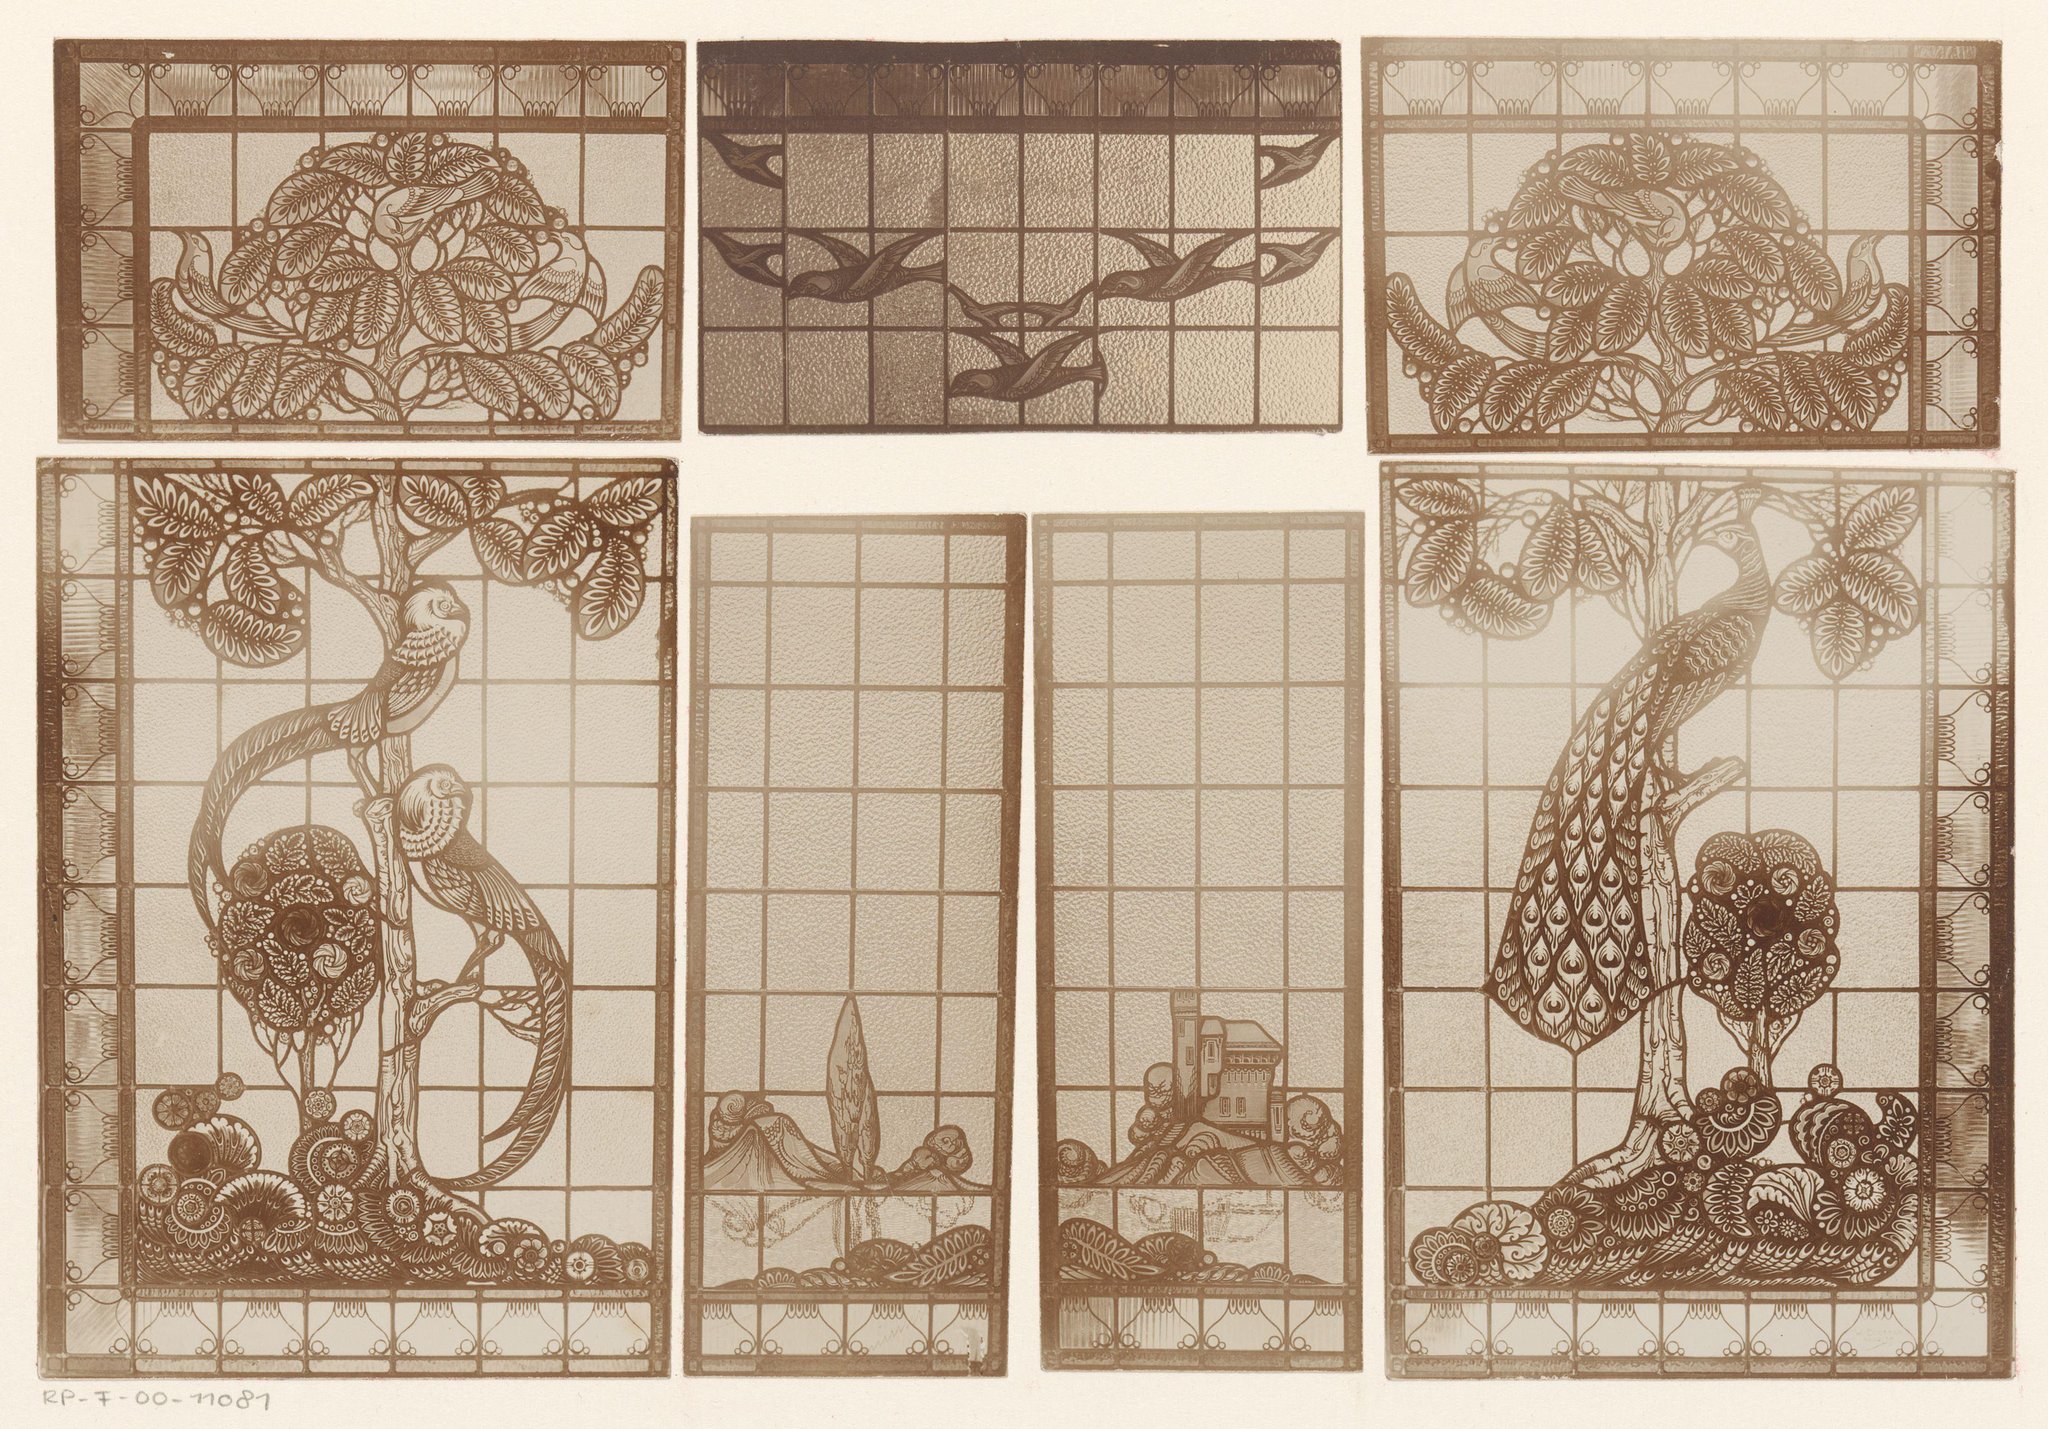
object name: photograph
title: Glas in loodramen met bomen met vogels en een pauw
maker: Anonymous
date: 1907-1930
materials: photographic support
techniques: collodion silver print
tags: trees, birds, ornamental birds: peacock, work of monumental art, farm or solitary house in landscape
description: Tevens een heuvellandschap met een gebouw en vogels in vlucht.